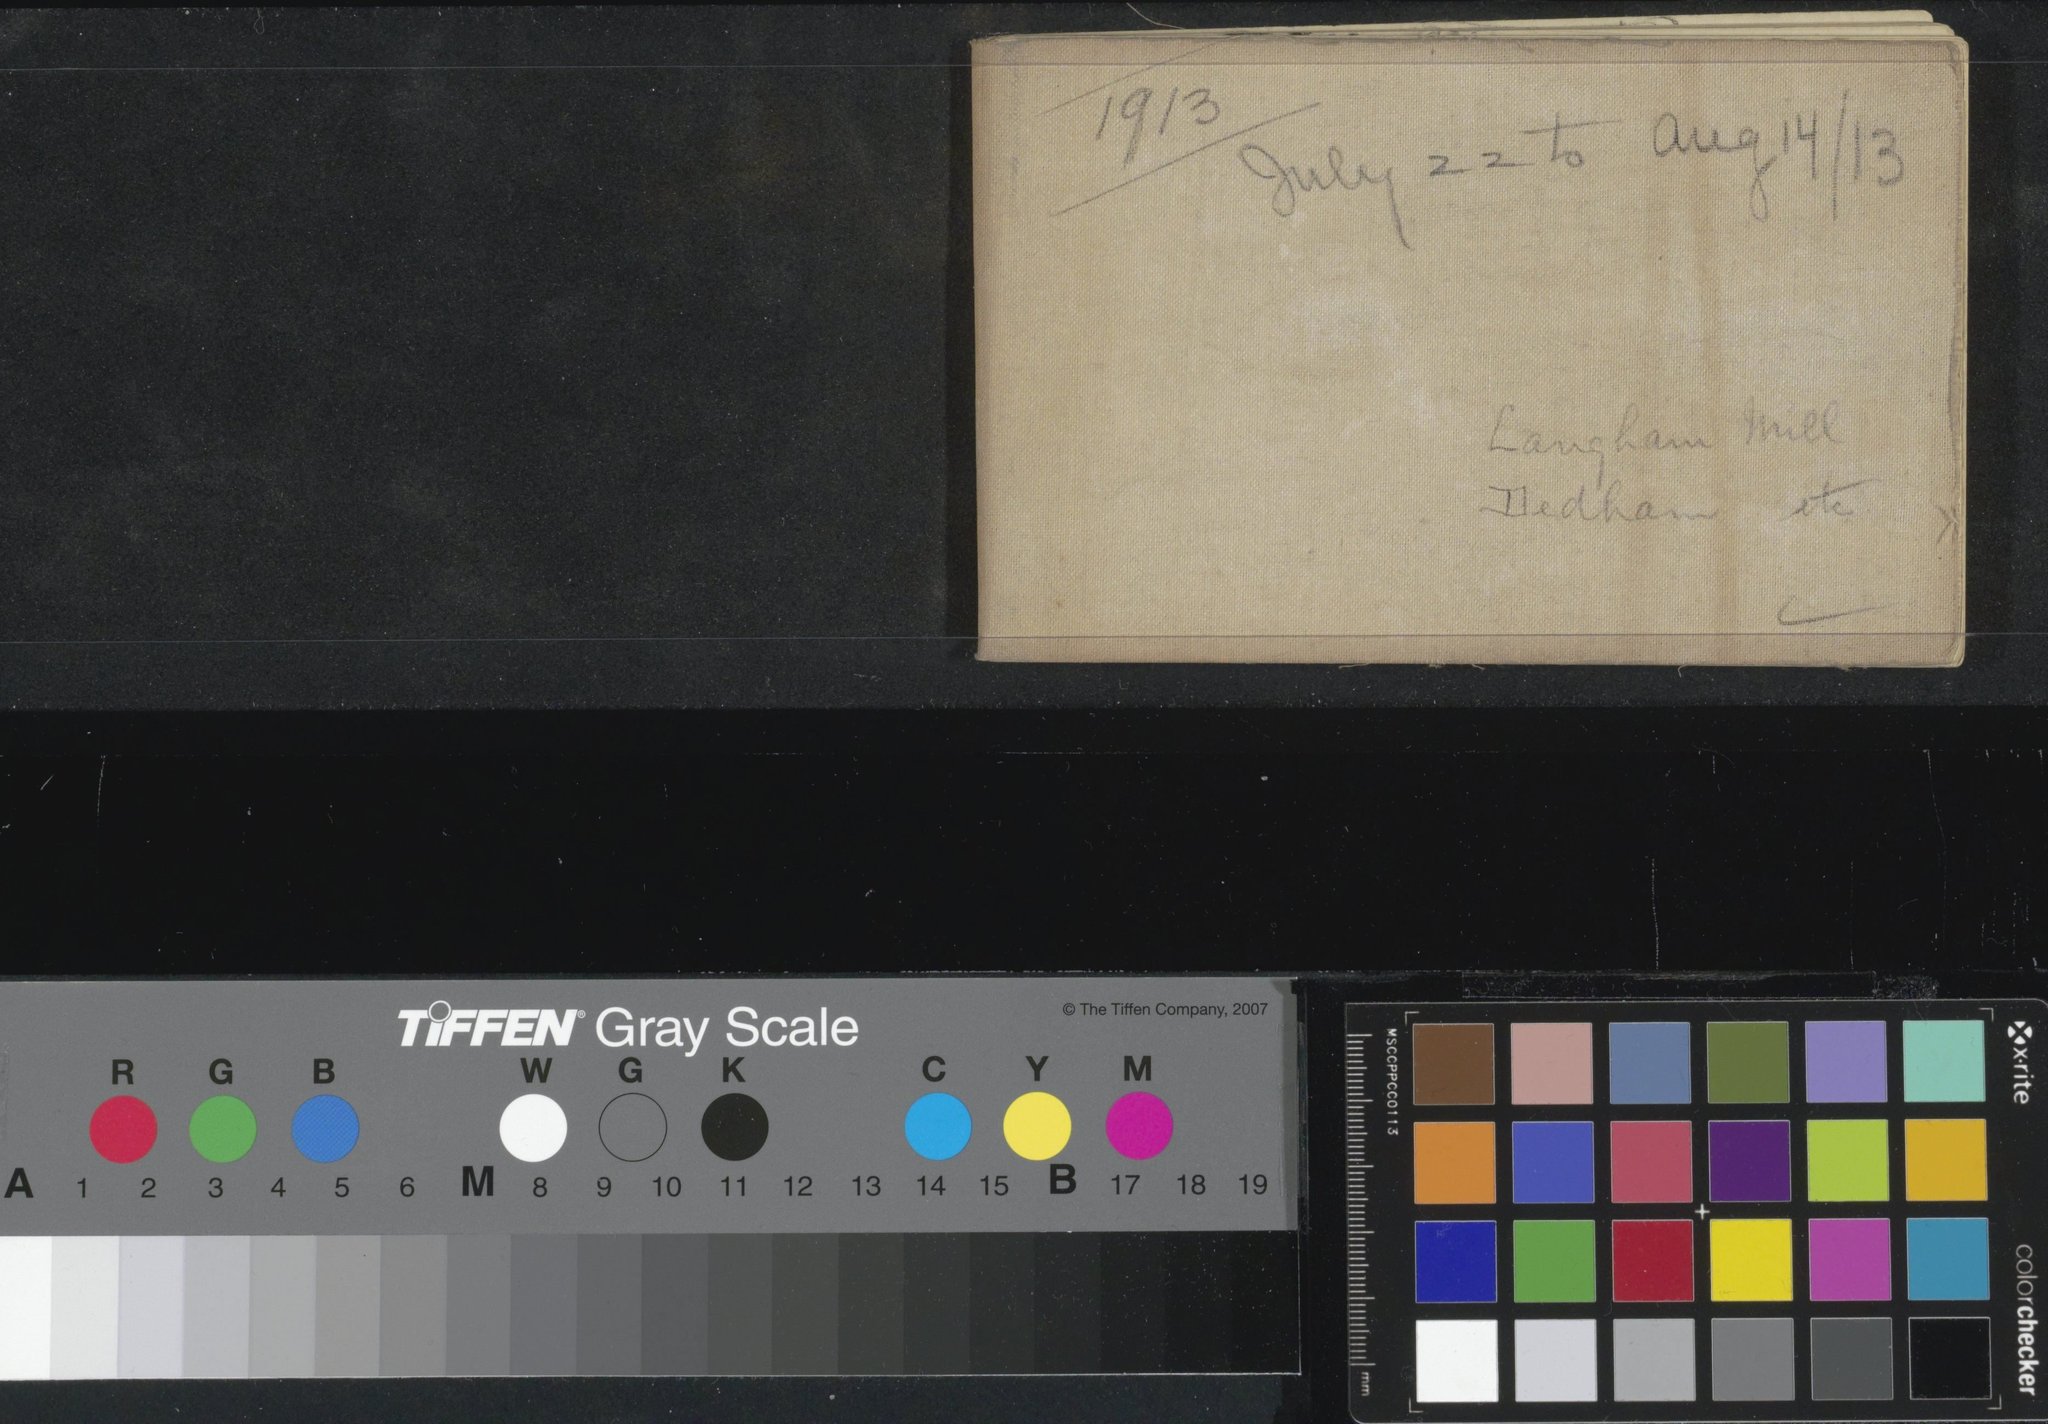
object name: sketchbook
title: Schetsboek met 30 bladen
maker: alexander shilling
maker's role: draughtsman, print maker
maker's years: 1859-1937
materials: chalk, linen, paper, pencil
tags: landscapes with waters, waterscapes, seascapes (in the temperate zone), bridge, hay-wagon, farm (building)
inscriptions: date and inscription: ‘Alexander Shilling/ Landschap shetsen [sic]/ uit Langham Mill/ Denham enz. in/ Engeland/ van 22 Juli tot/ 14 Aug. 1913’, date and inscription: ‘1913/ July 22 to aug 14/13/ Langham Mill/ Dedham etc.’, annotation: ‘contable/ sturge Henderson/ duel[...]/ -1905/ Den[...] & co’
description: Bladen 1(V) t/m 30(V) zijn blanco. Shilling heeft in Engeland gewerkt op de plaatsen waar John Constable (1776-1837) veel werkte rond de rivier Stour. De annotatie voorin het schetsboek laat zien dat Shilling zich vermoedelijk verdiept heeft in het leven en werk van Constable.